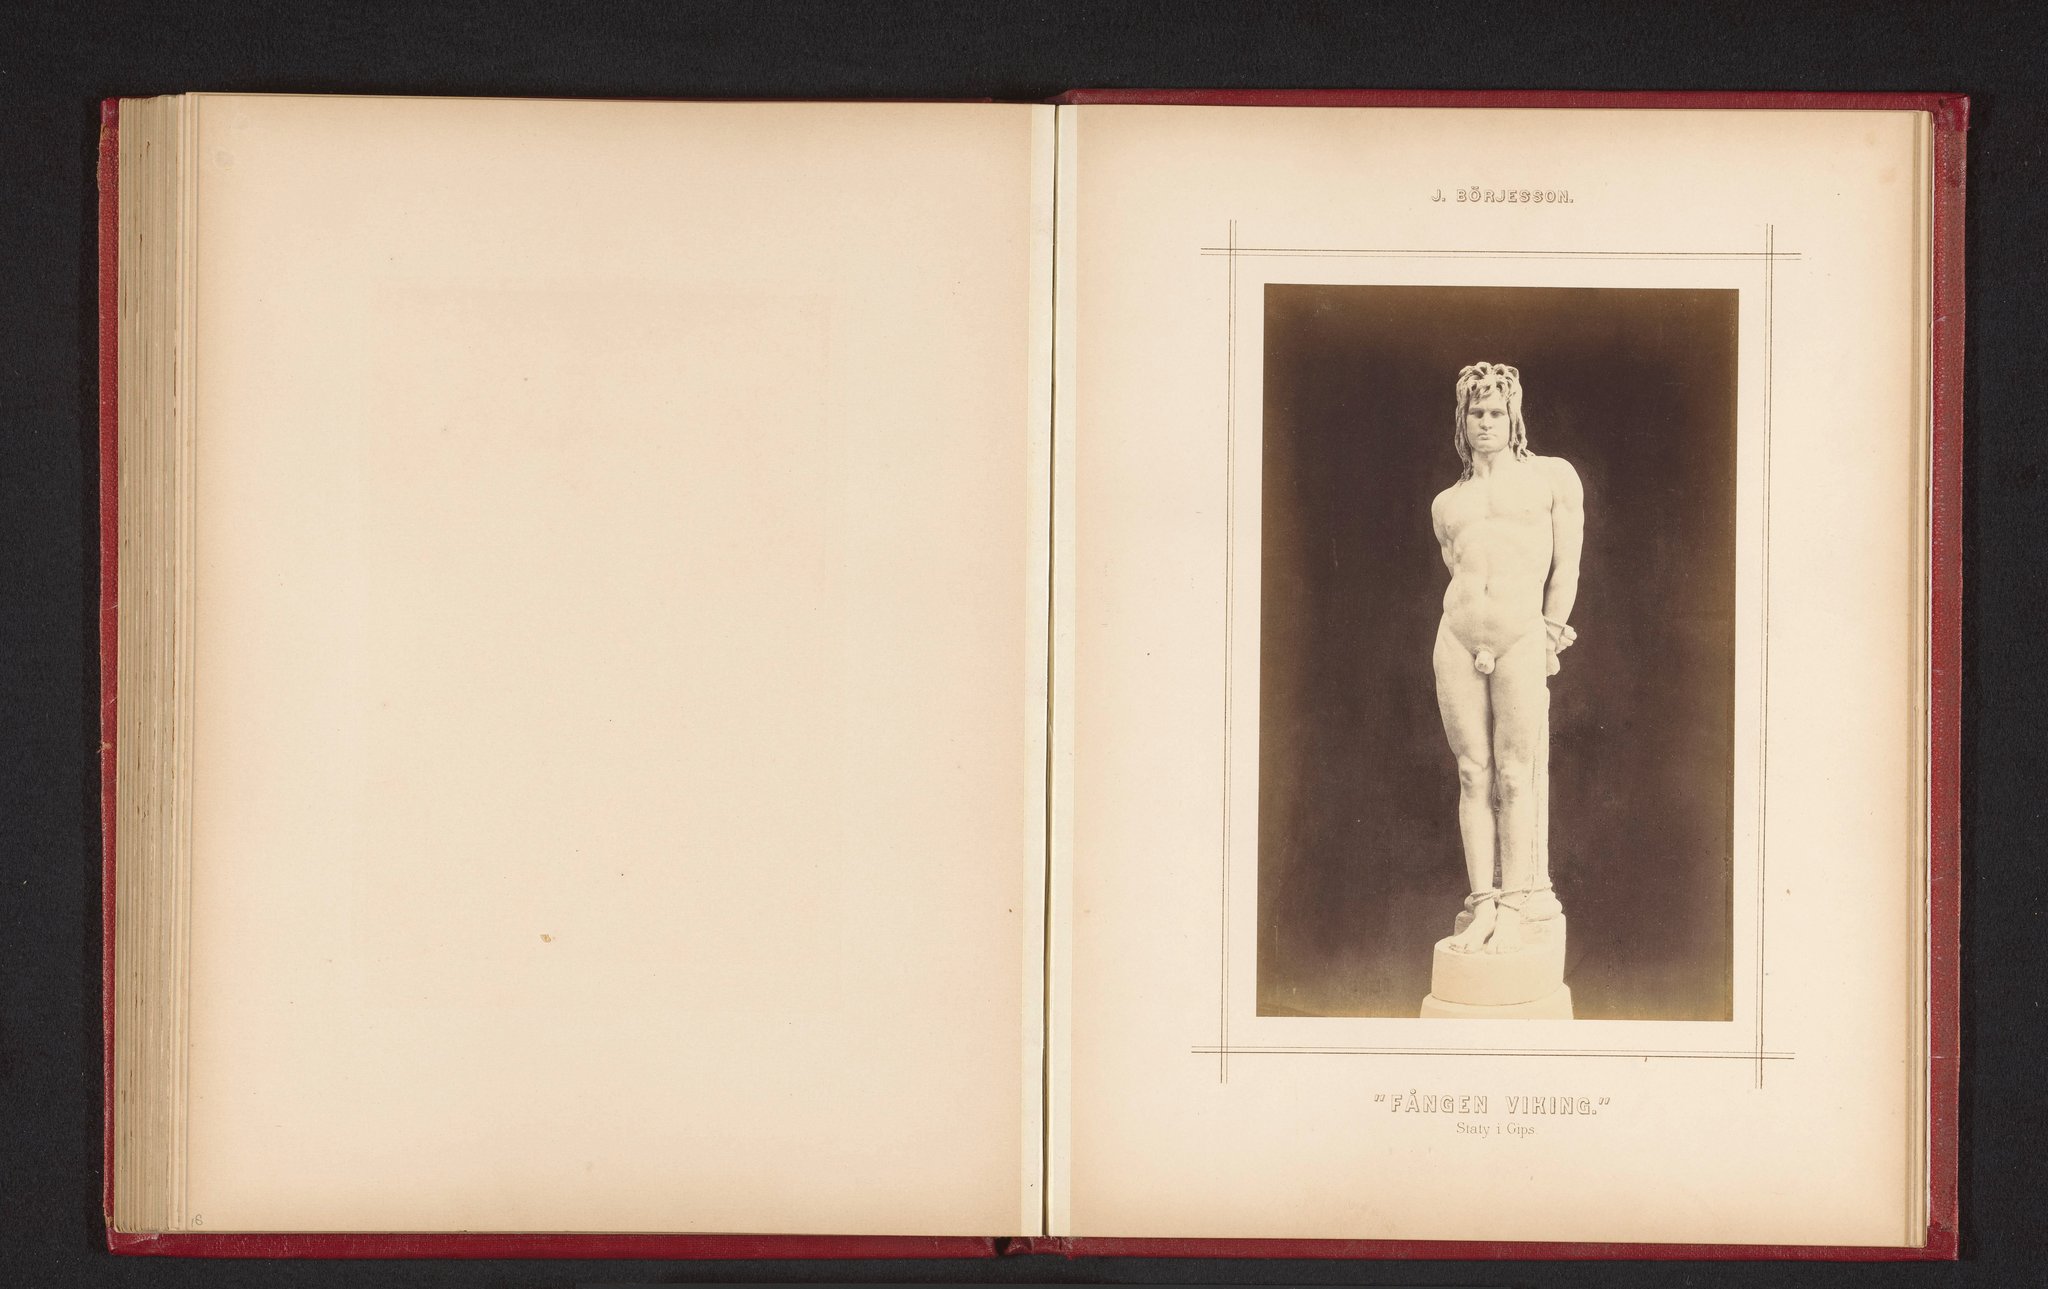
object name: photograph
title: Fången Viking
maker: johannes jaeger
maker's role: fotograaf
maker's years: 1832-1908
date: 1874-1879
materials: photographic support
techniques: albumen print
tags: piece of sculpture, reproduction of a piece of sculpture, prisoner of war (after the battle), man (showing himself) undressed, quasi-nude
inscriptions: inscription: ‘Staty i Gips.’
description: Foto op derde ongenummerde pagina na pagina 82.